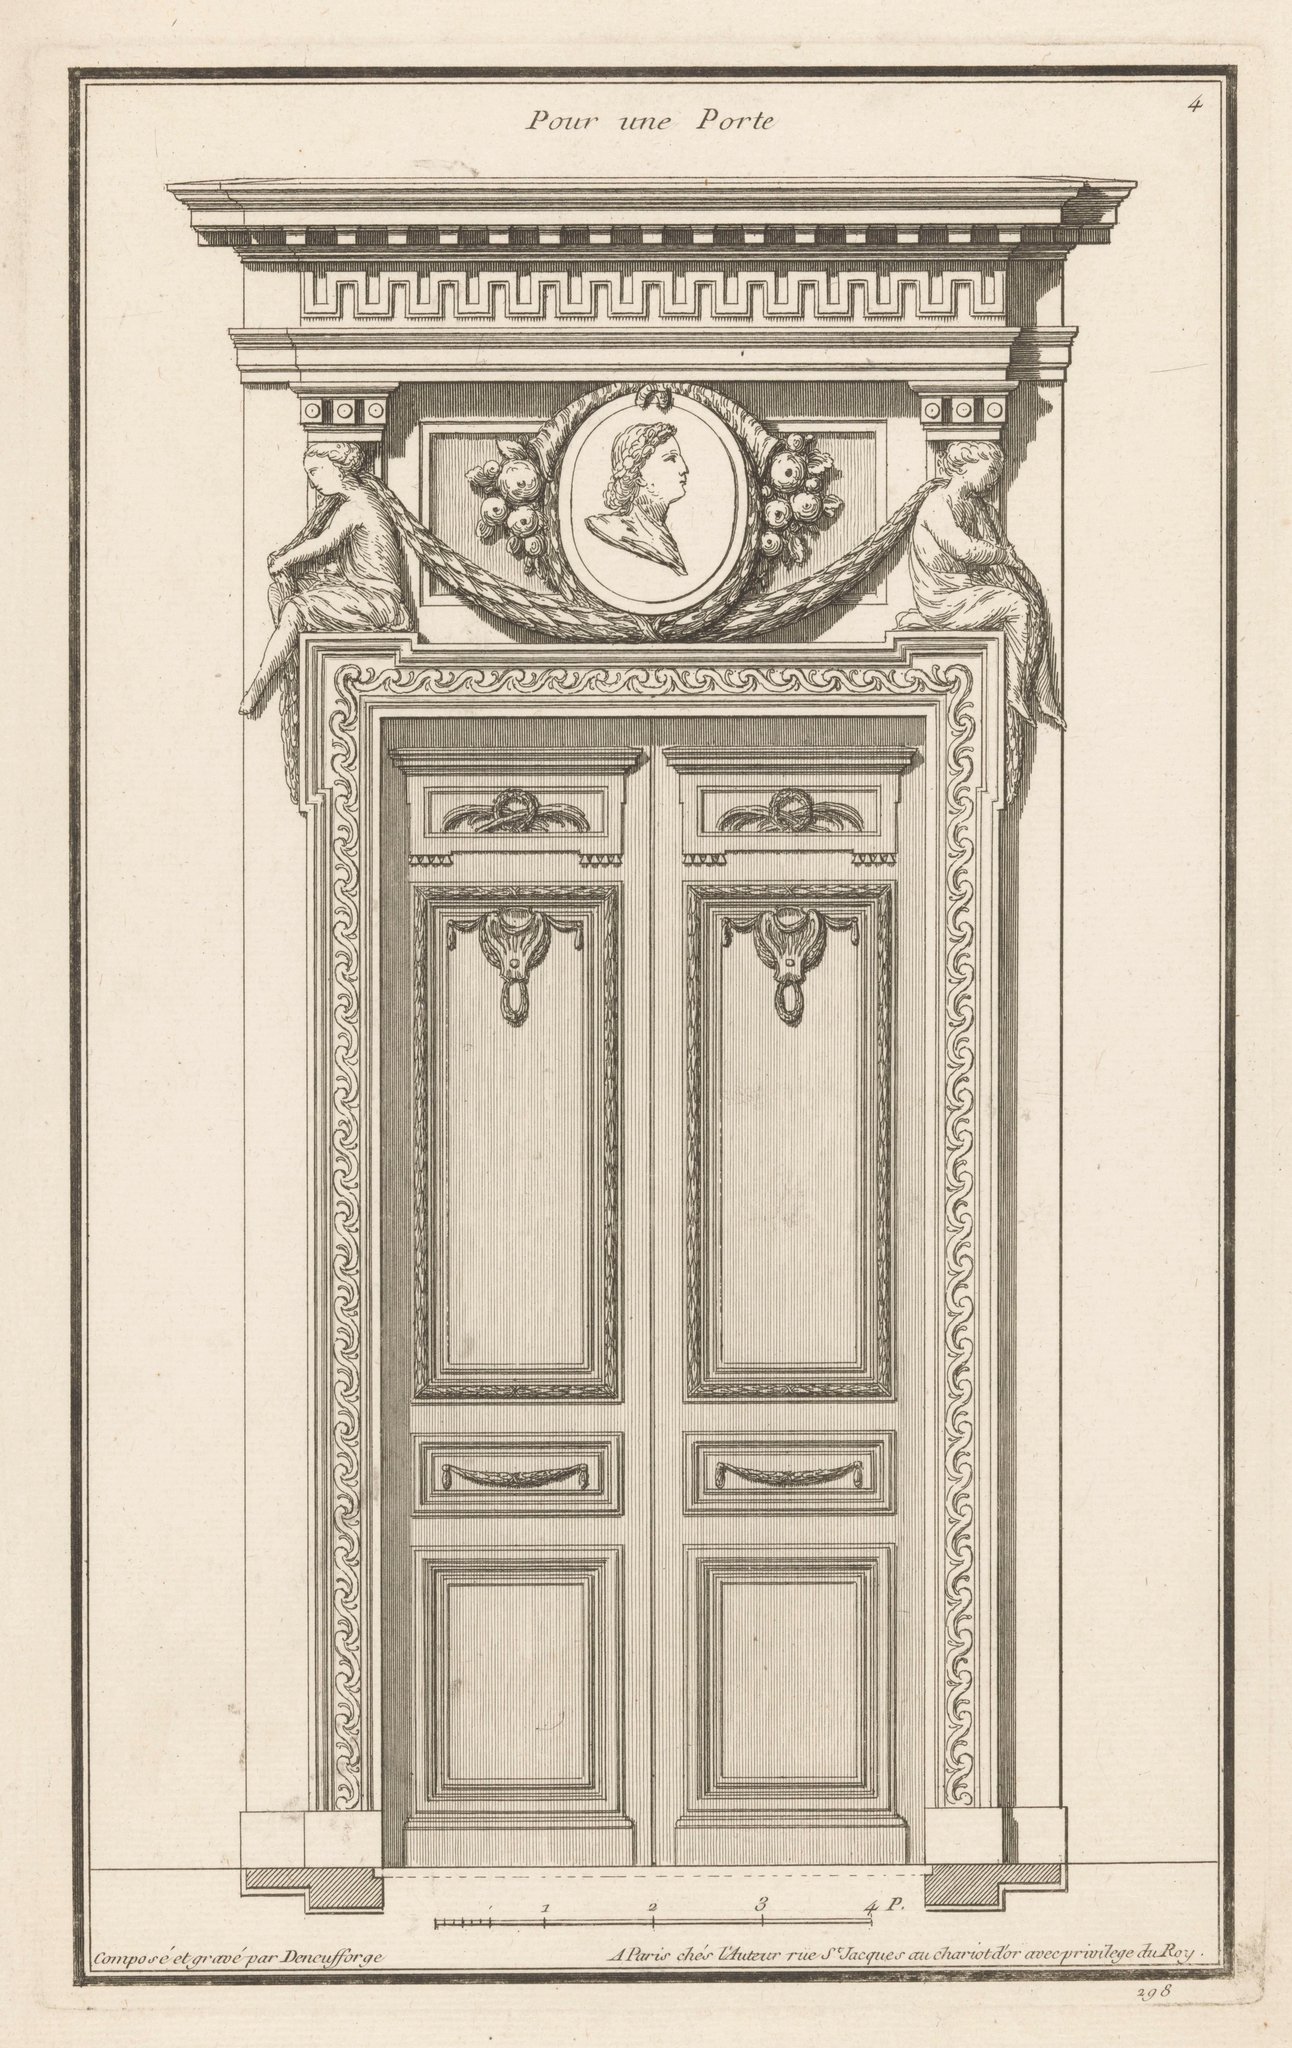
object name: print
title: Pour un Porte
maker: jean françois de neufforge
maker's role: print maker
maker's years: 1714-1791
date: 1763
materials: paper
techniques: etching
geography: paris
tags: 'cornucopia', horn of plenty, monumental door, porch, 'aediculum', ornament ~ medallion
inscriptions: collector's mark: Lugt 2228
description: Een geornamenteerde deur met rocailles en guirlandes. Daarboven een medaillon met vrouwenportret en profil, hoornen des overvloeds en twee zittende figuren met guirlandes. Prentnummer 298.